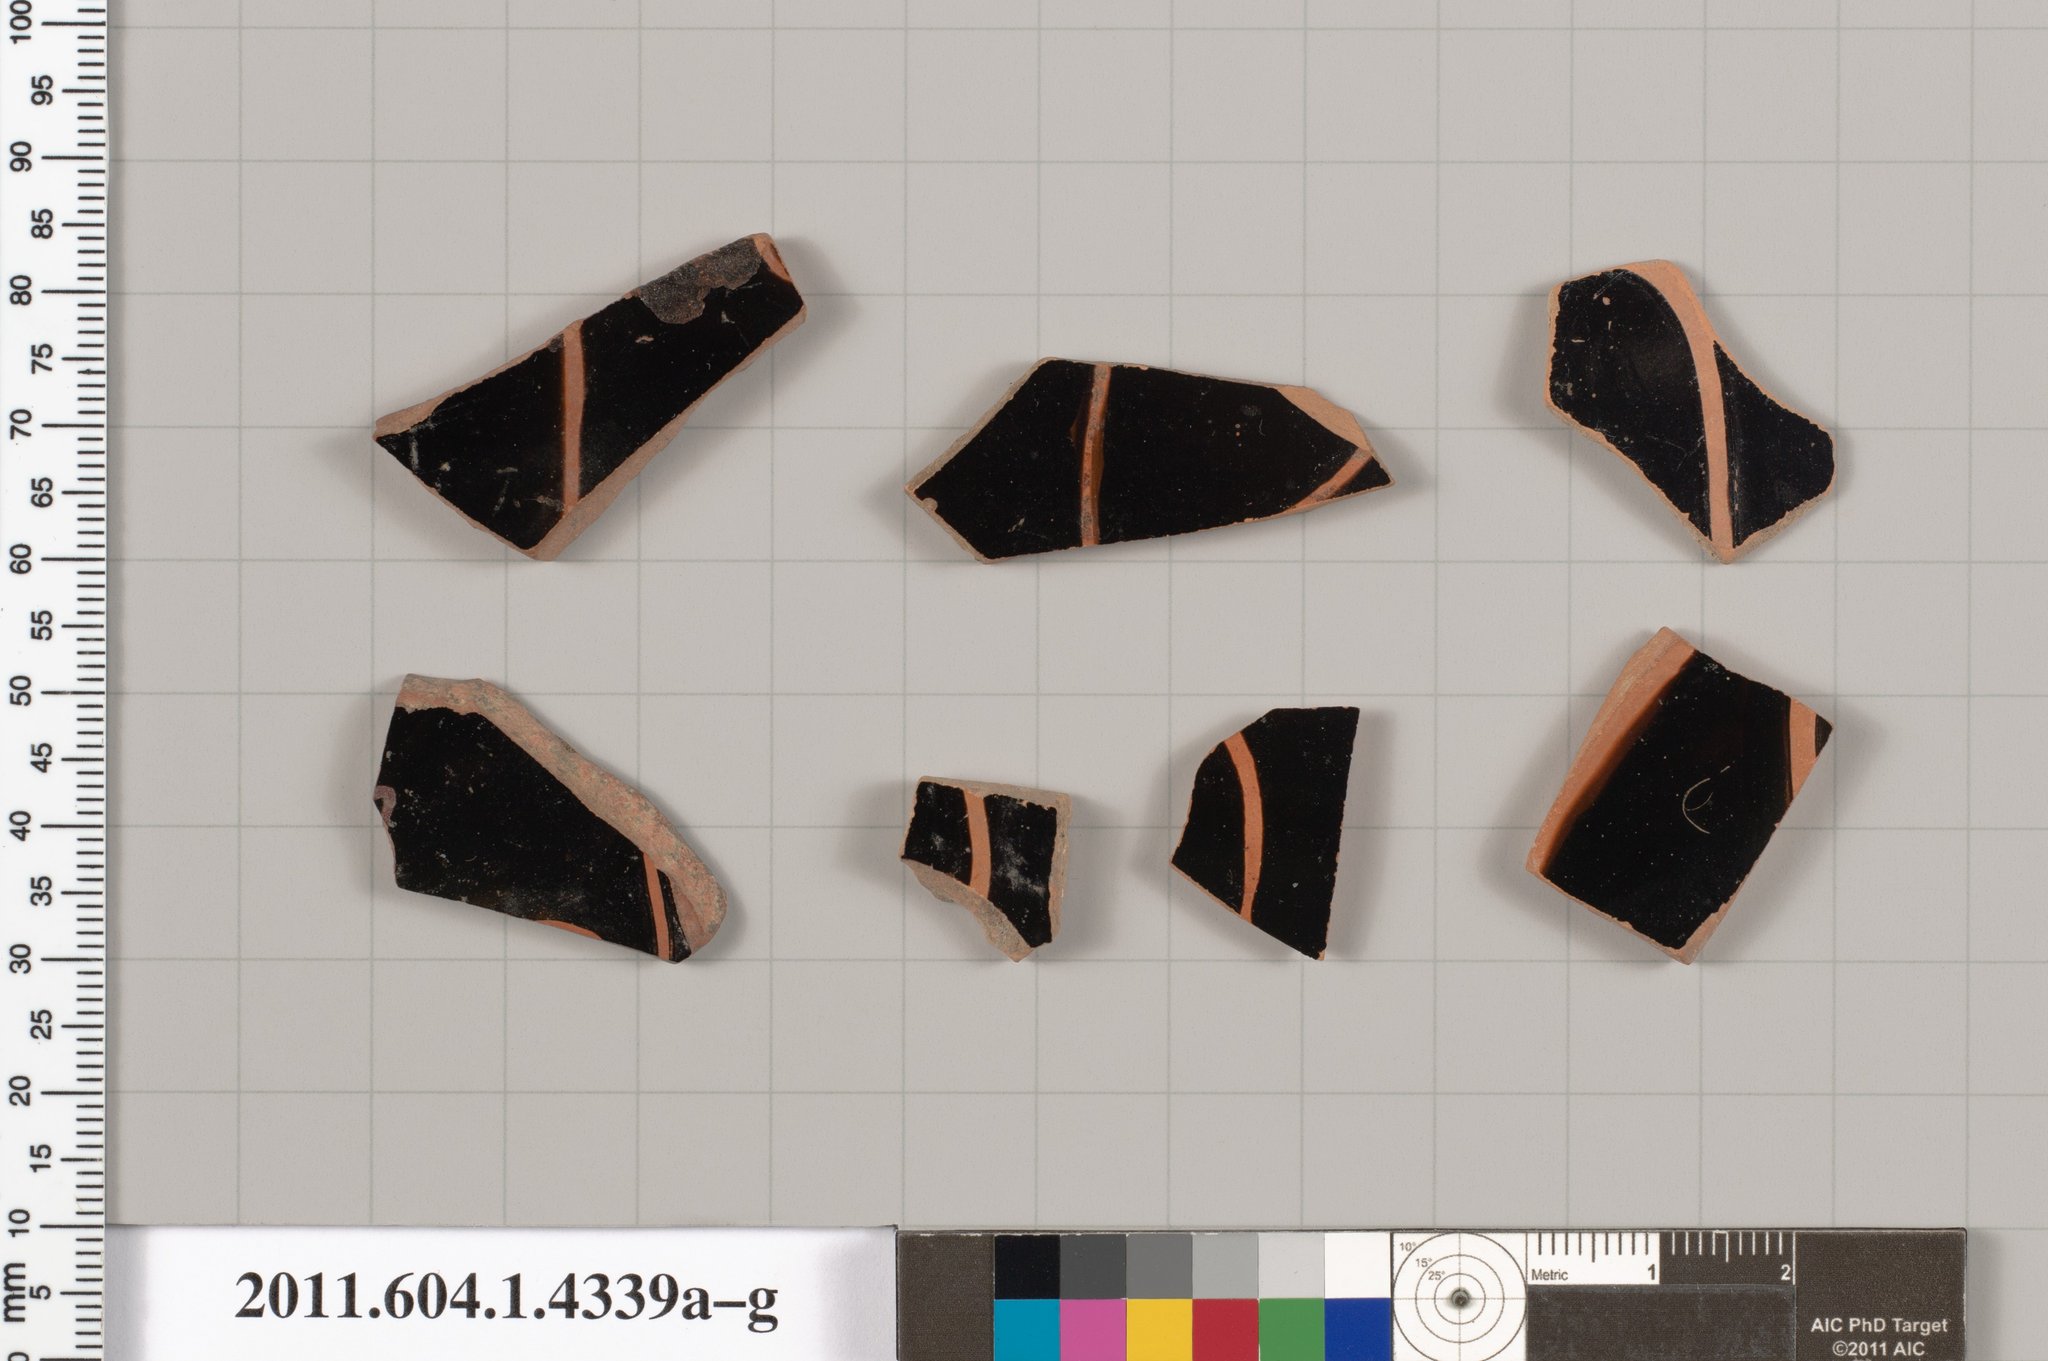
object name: kylix fragment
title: Terracotta fragments of kylikes (drinking cups)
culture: greek, attic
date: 500-451 BCE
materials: terracotta